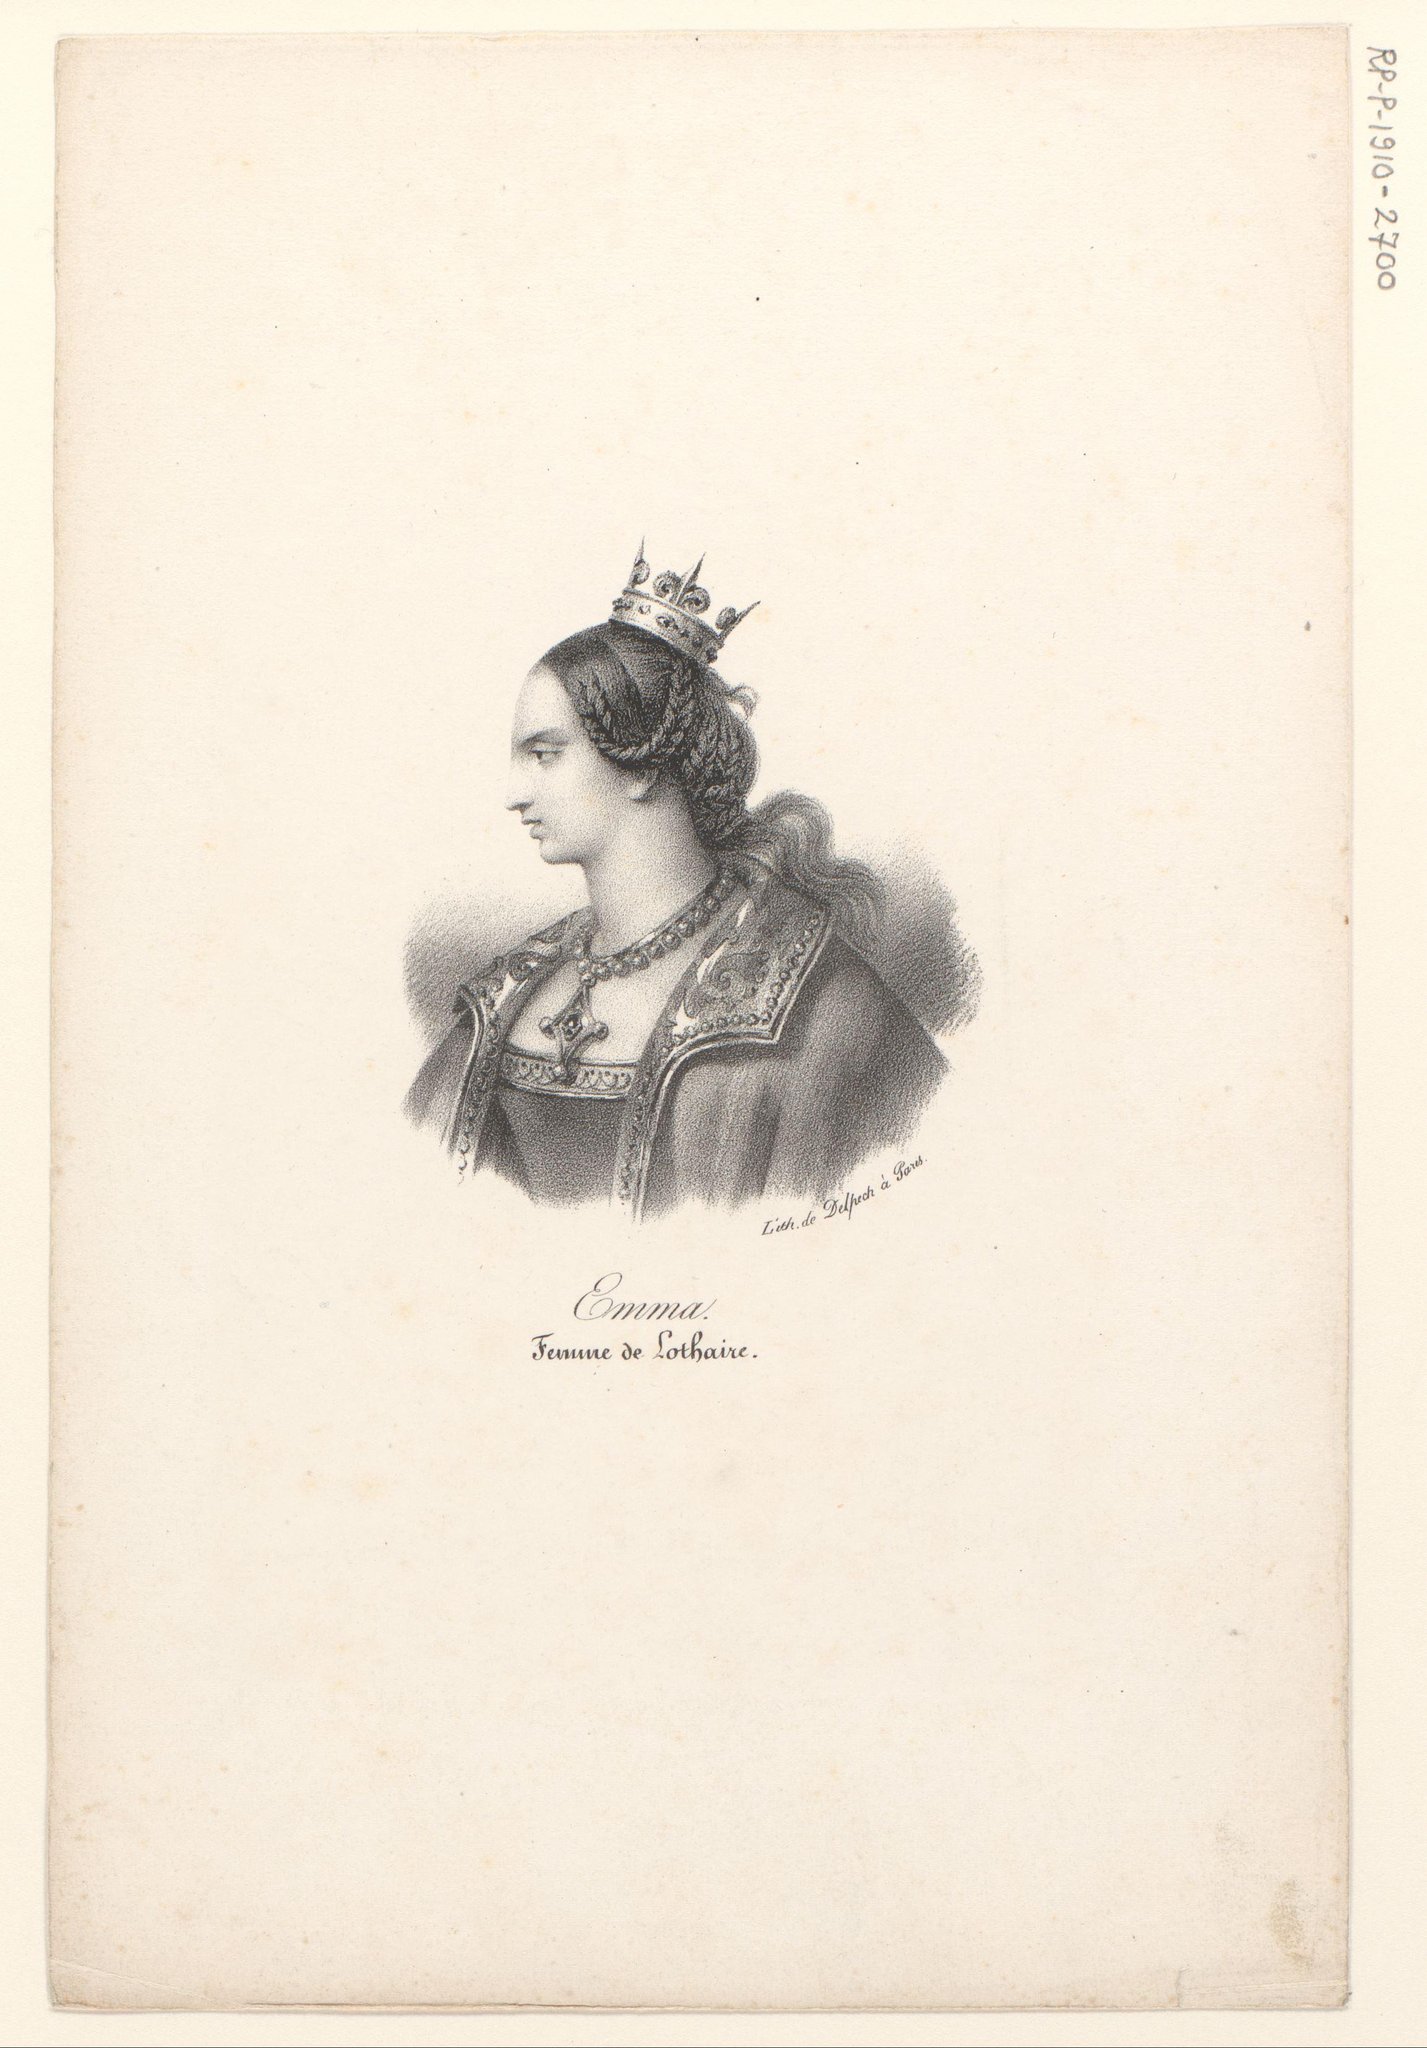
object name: print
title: Emma, femme de Lothaire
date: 1818-1842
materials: paper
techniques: lithograph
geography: paris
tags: historical persons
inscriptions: collector's mark: Lugt 2228a